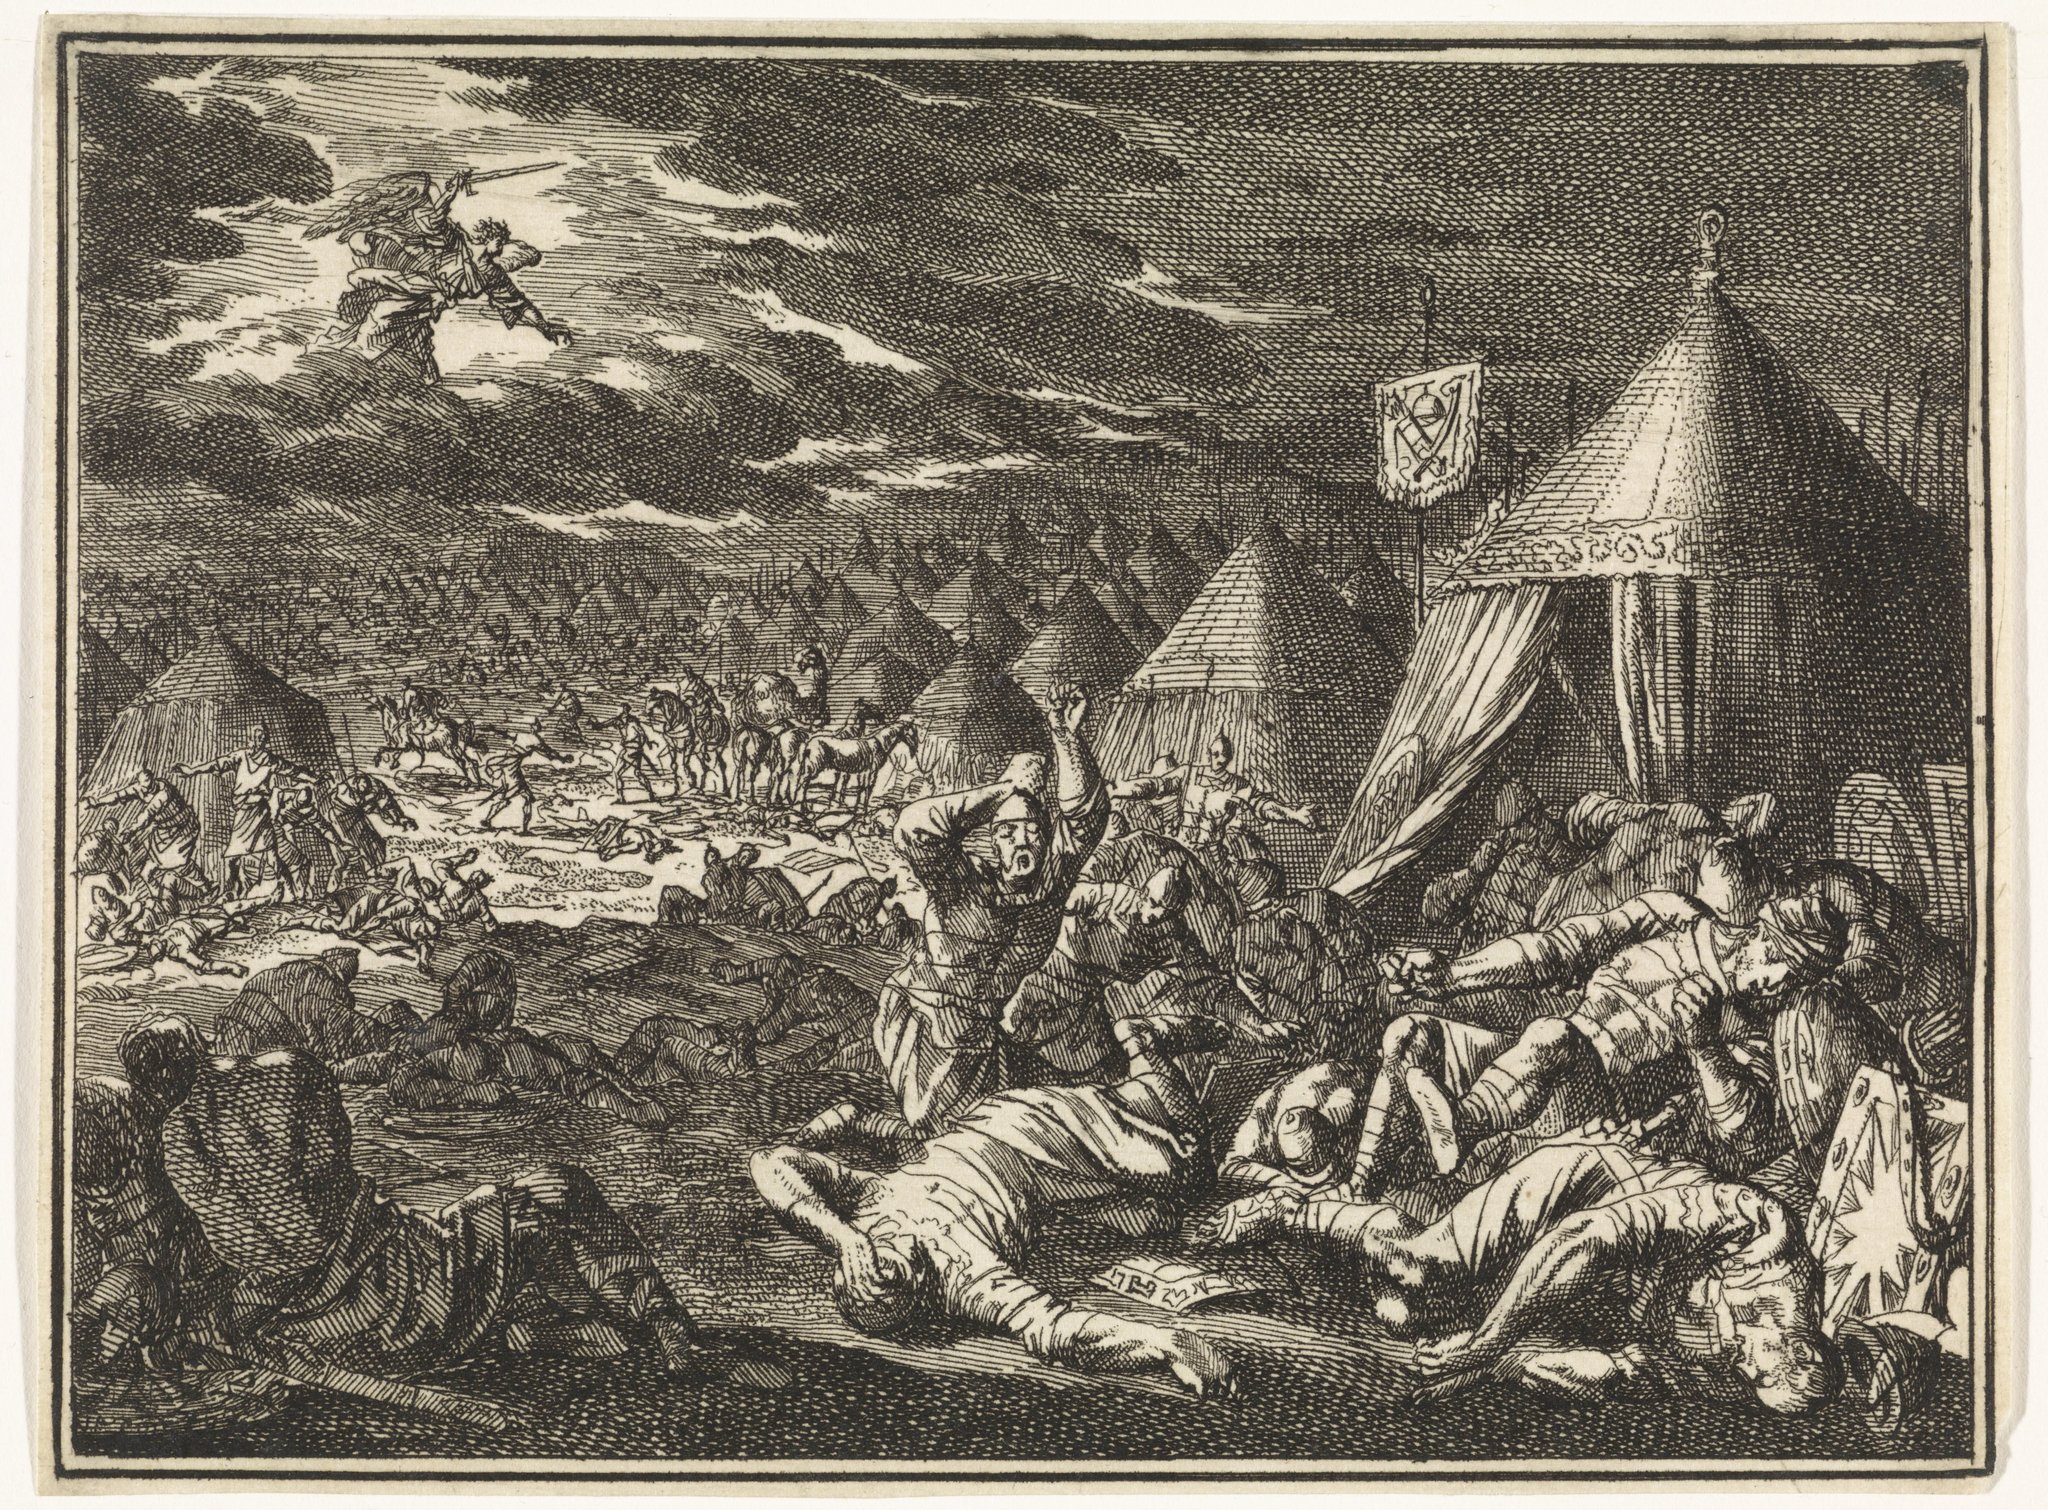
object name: print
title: Engel des Heren doodt de troepen van Sanherib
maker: jan luyken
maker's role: draughtsman, print maker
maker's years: 1649-1712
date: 1712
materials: paper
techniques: etching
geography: amsterdam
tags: at night, an angel of the lord decimates the assyrian camp: 185.000 soldiers are killed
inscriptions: number: ‘155’, collector's mark: Lugt 2228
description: Illustratie uit: Luyken, Jan. De schriftuurlyke geschiedenissen en gelykenissen van het Oude en Nieuwe Verbond, 2 delen. Amsterdam: Wed. Pieter Arentsz II en Cornelis van der Sys, 1712, dl. I.